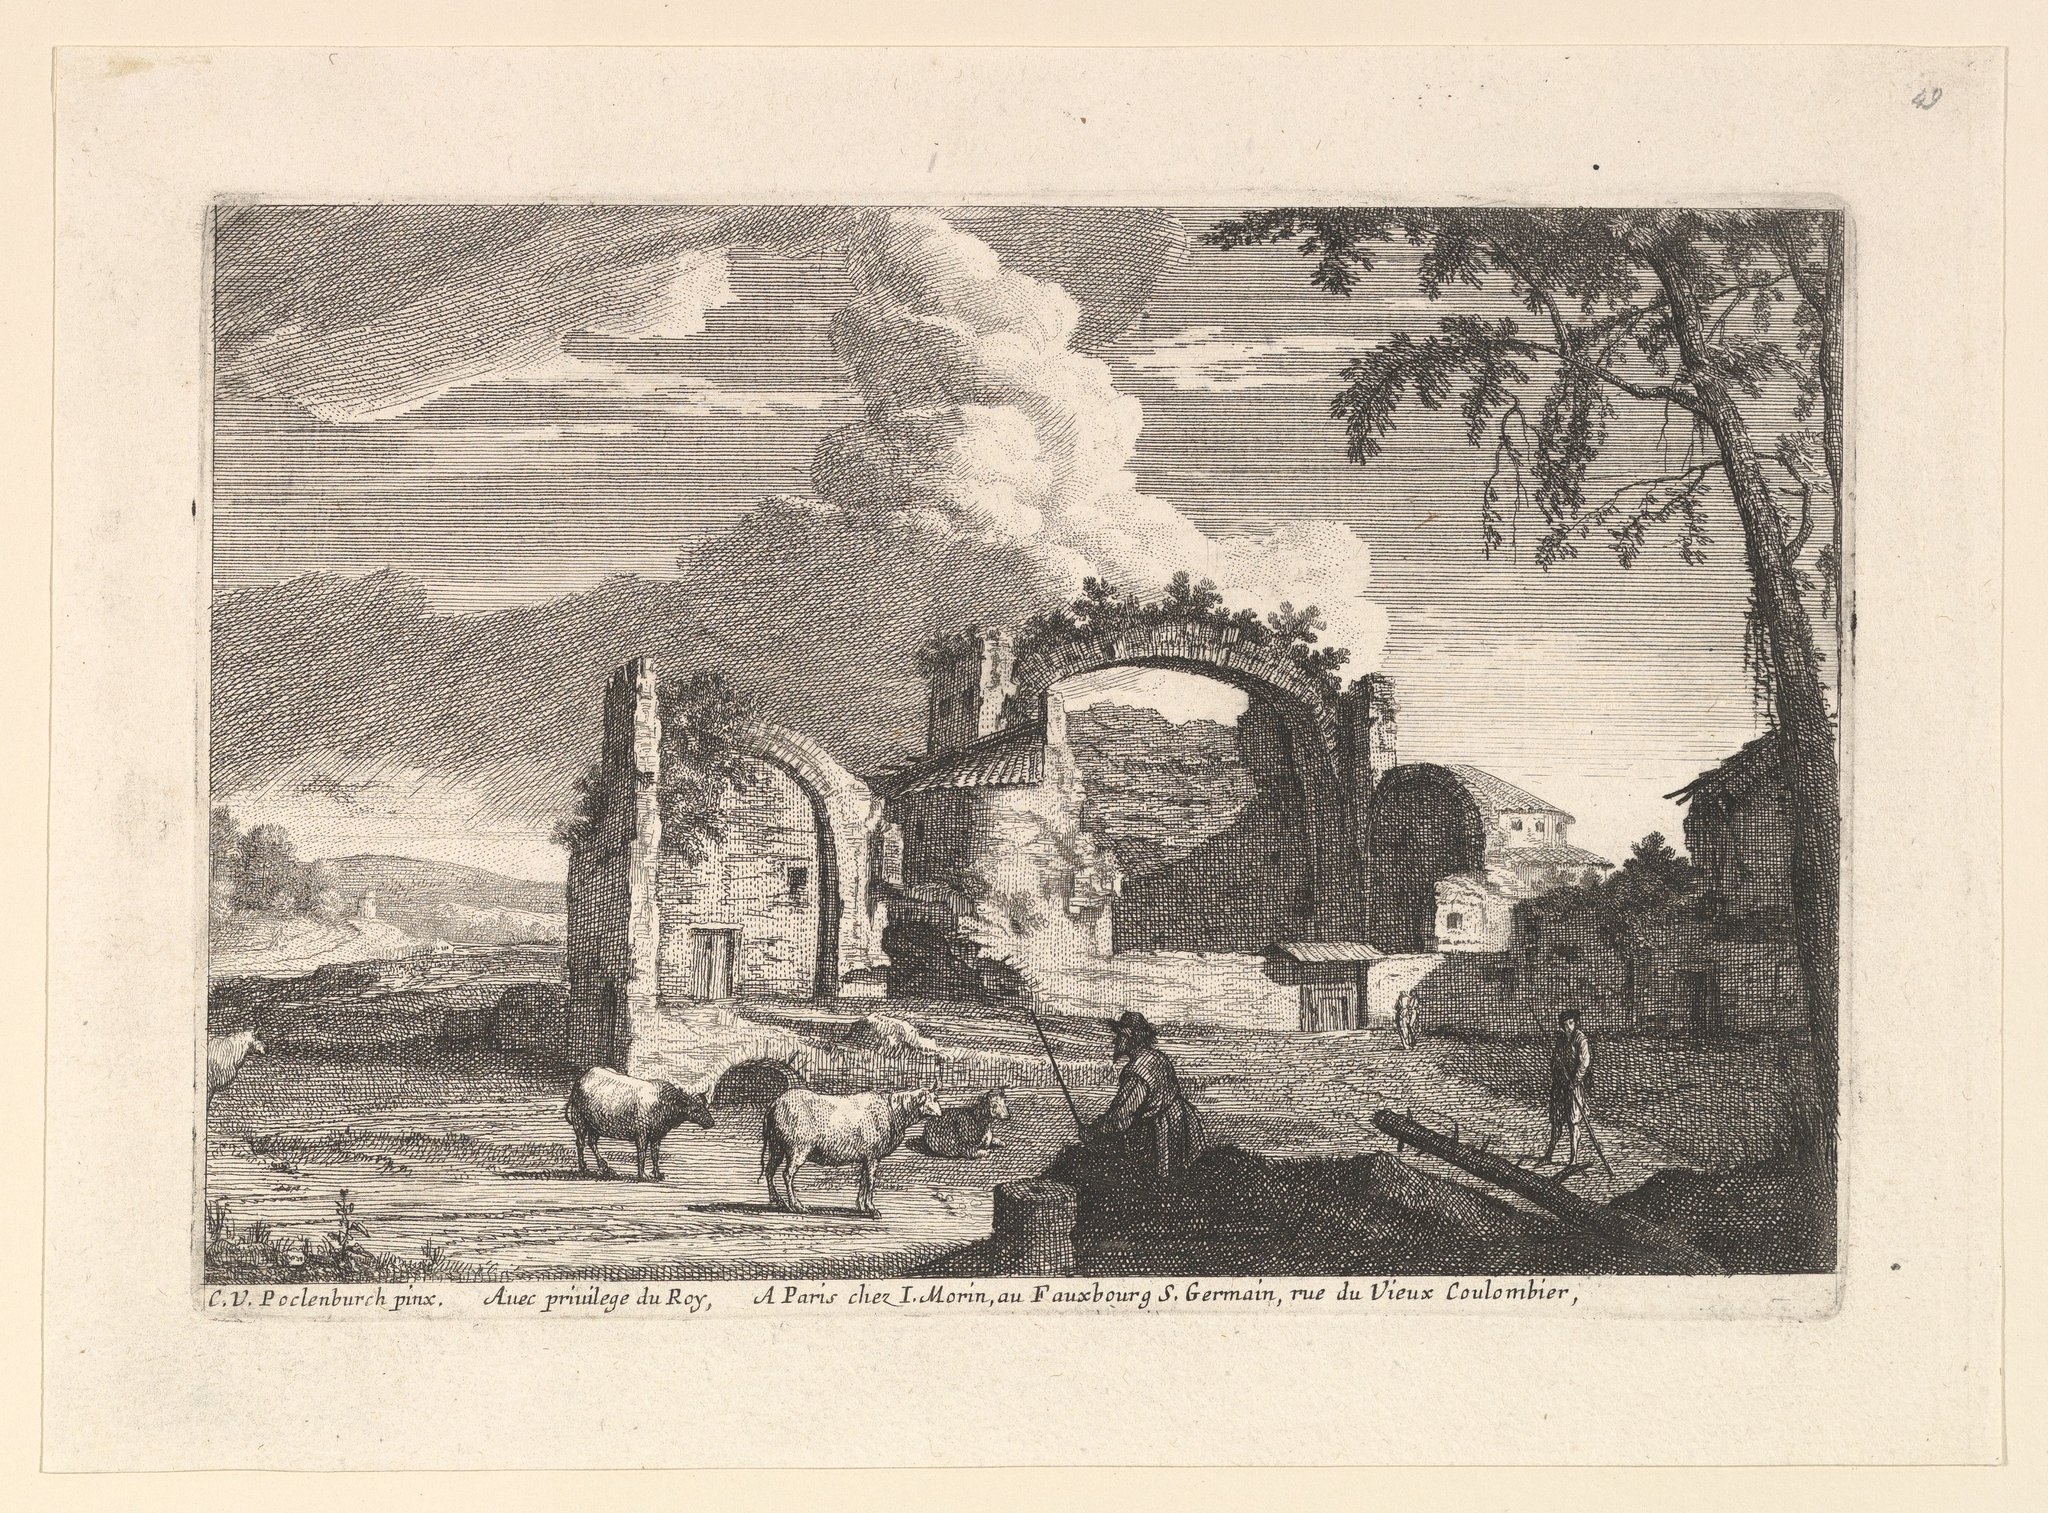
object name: print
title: Le Bouvier Assis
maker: jean morin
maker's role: artist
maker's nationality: french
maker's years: 1605-1650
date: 1605-1650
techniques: etching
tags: ruins,men,cows